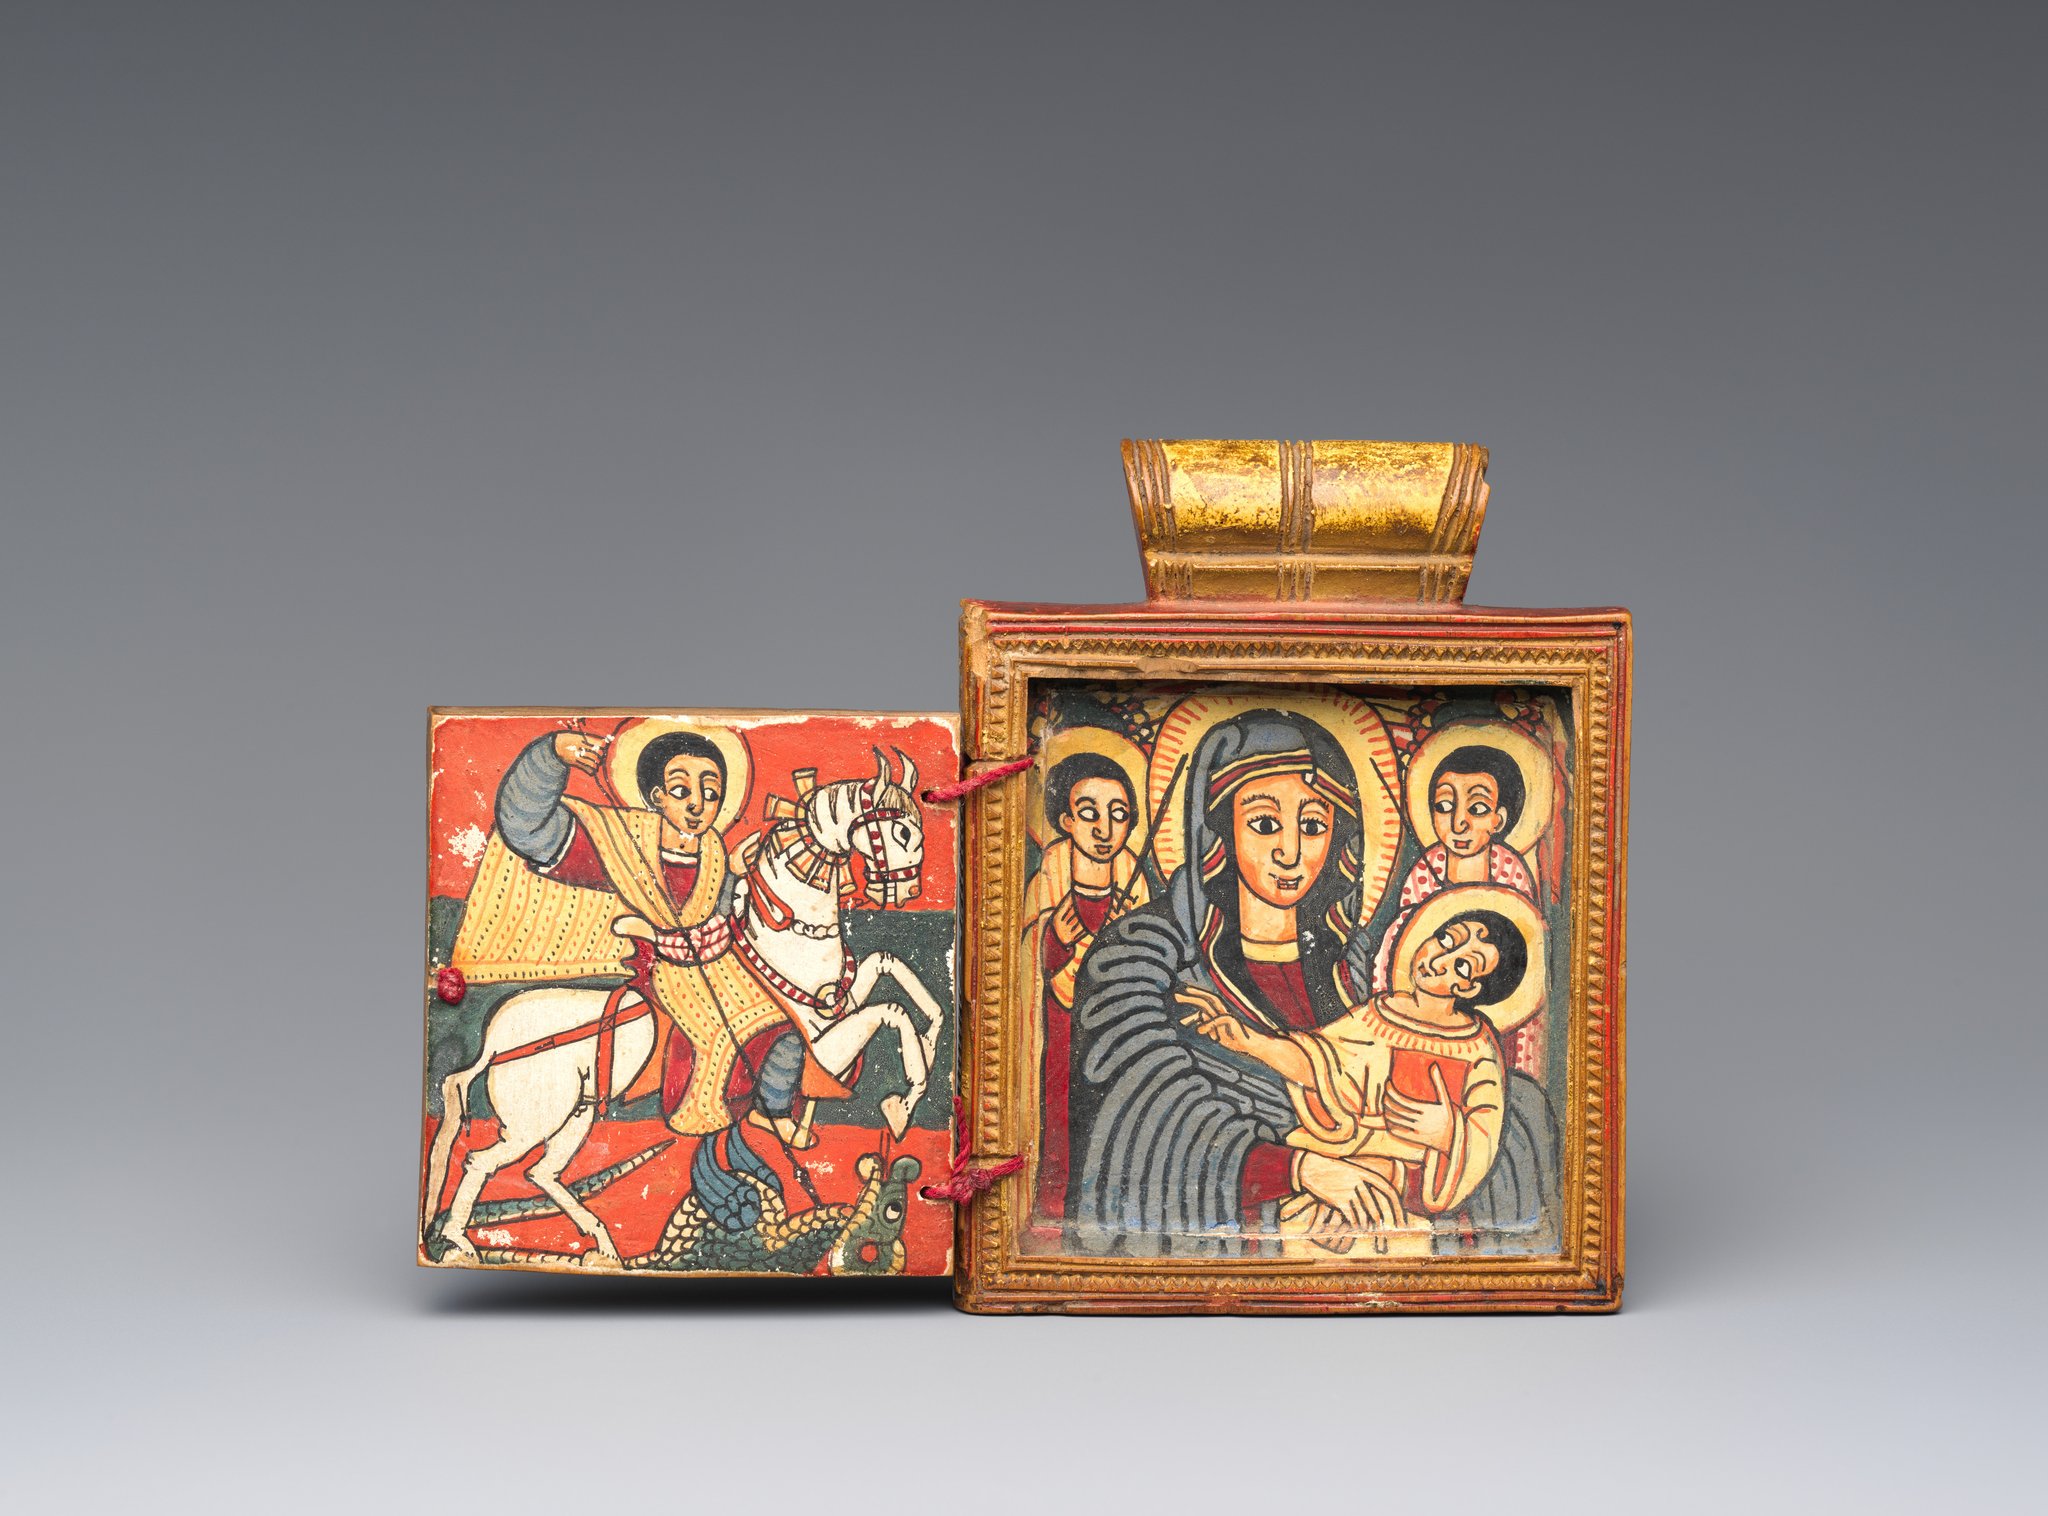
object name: icon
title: Double Diptych Icon Pendant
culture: amhara or tigrinya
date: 1701-1733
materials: pigment, paint, wood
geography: ethiopia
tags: dragons,horses,christ,saint george,virgin mary,crucifixion